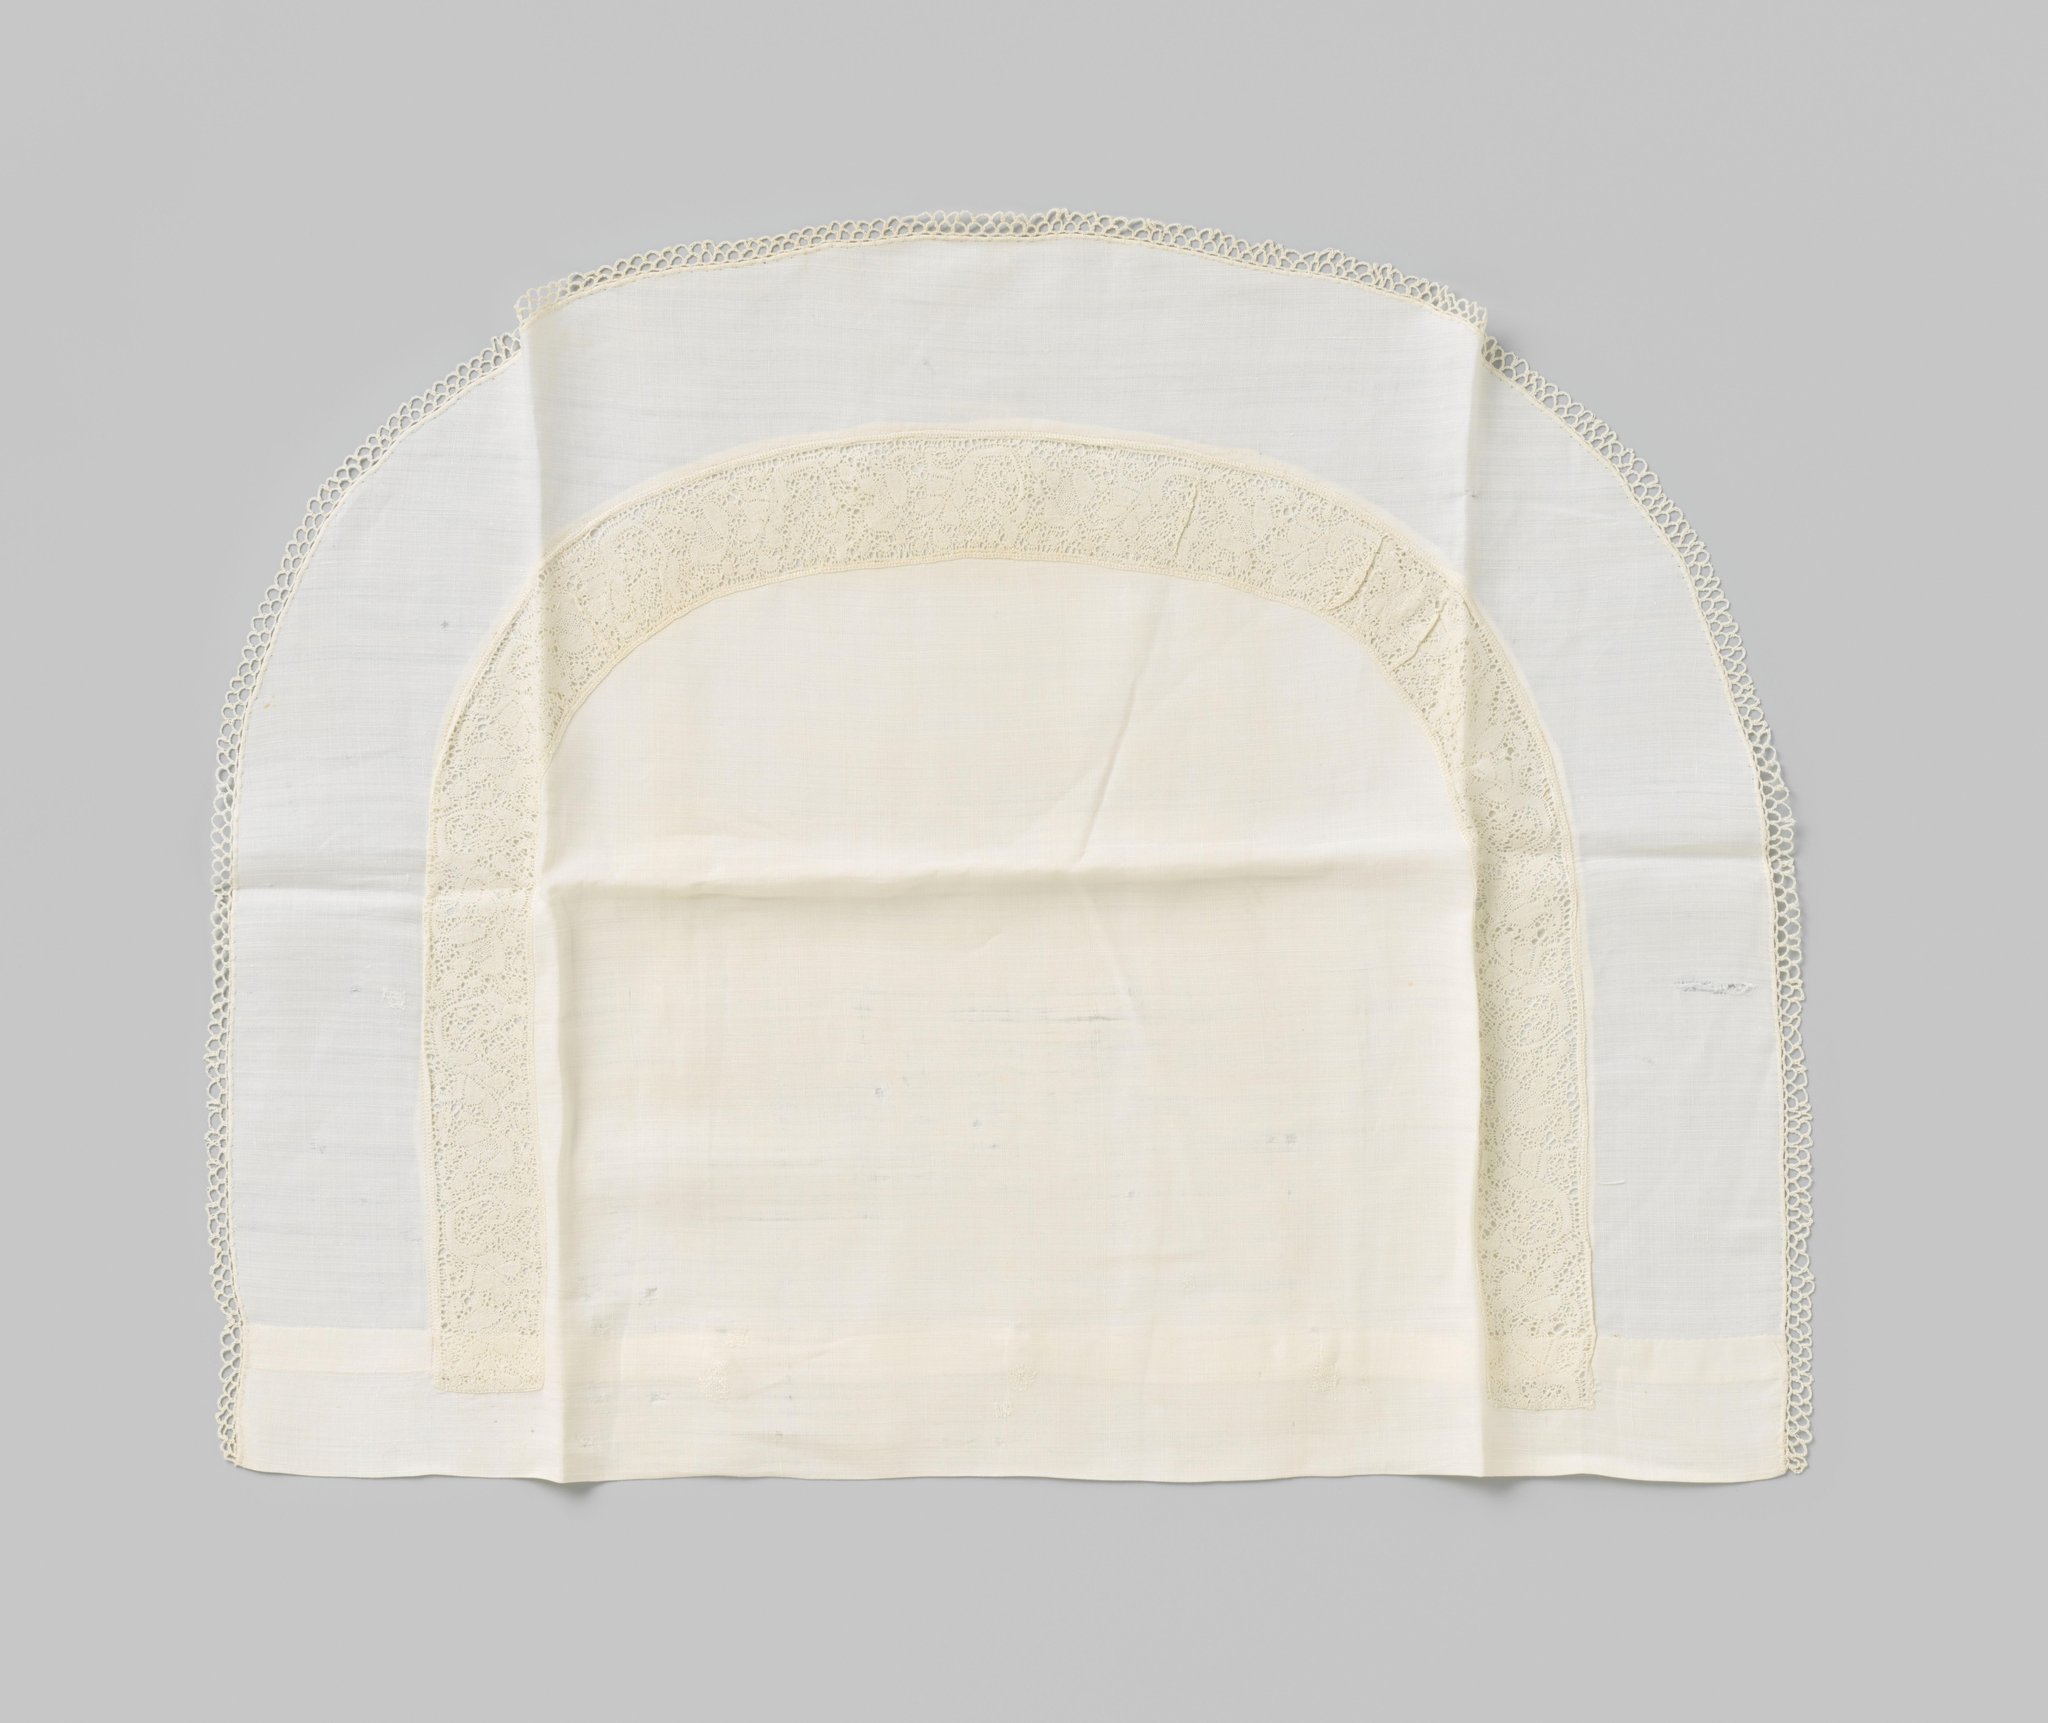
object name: sloop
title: Sloop van linnen met tussenzetsel van kant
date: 1700-1800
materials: linen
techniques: lace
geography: netherlands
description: Effen kussensloop van wit linnen, halfrond model met tussenzetsel van kant en aan afgeronde kant met haakwerk. Aan de voorzijde een aantal stoppen, kleine gaten en één scheur. Sluiting met drie knopen van parelmoer.